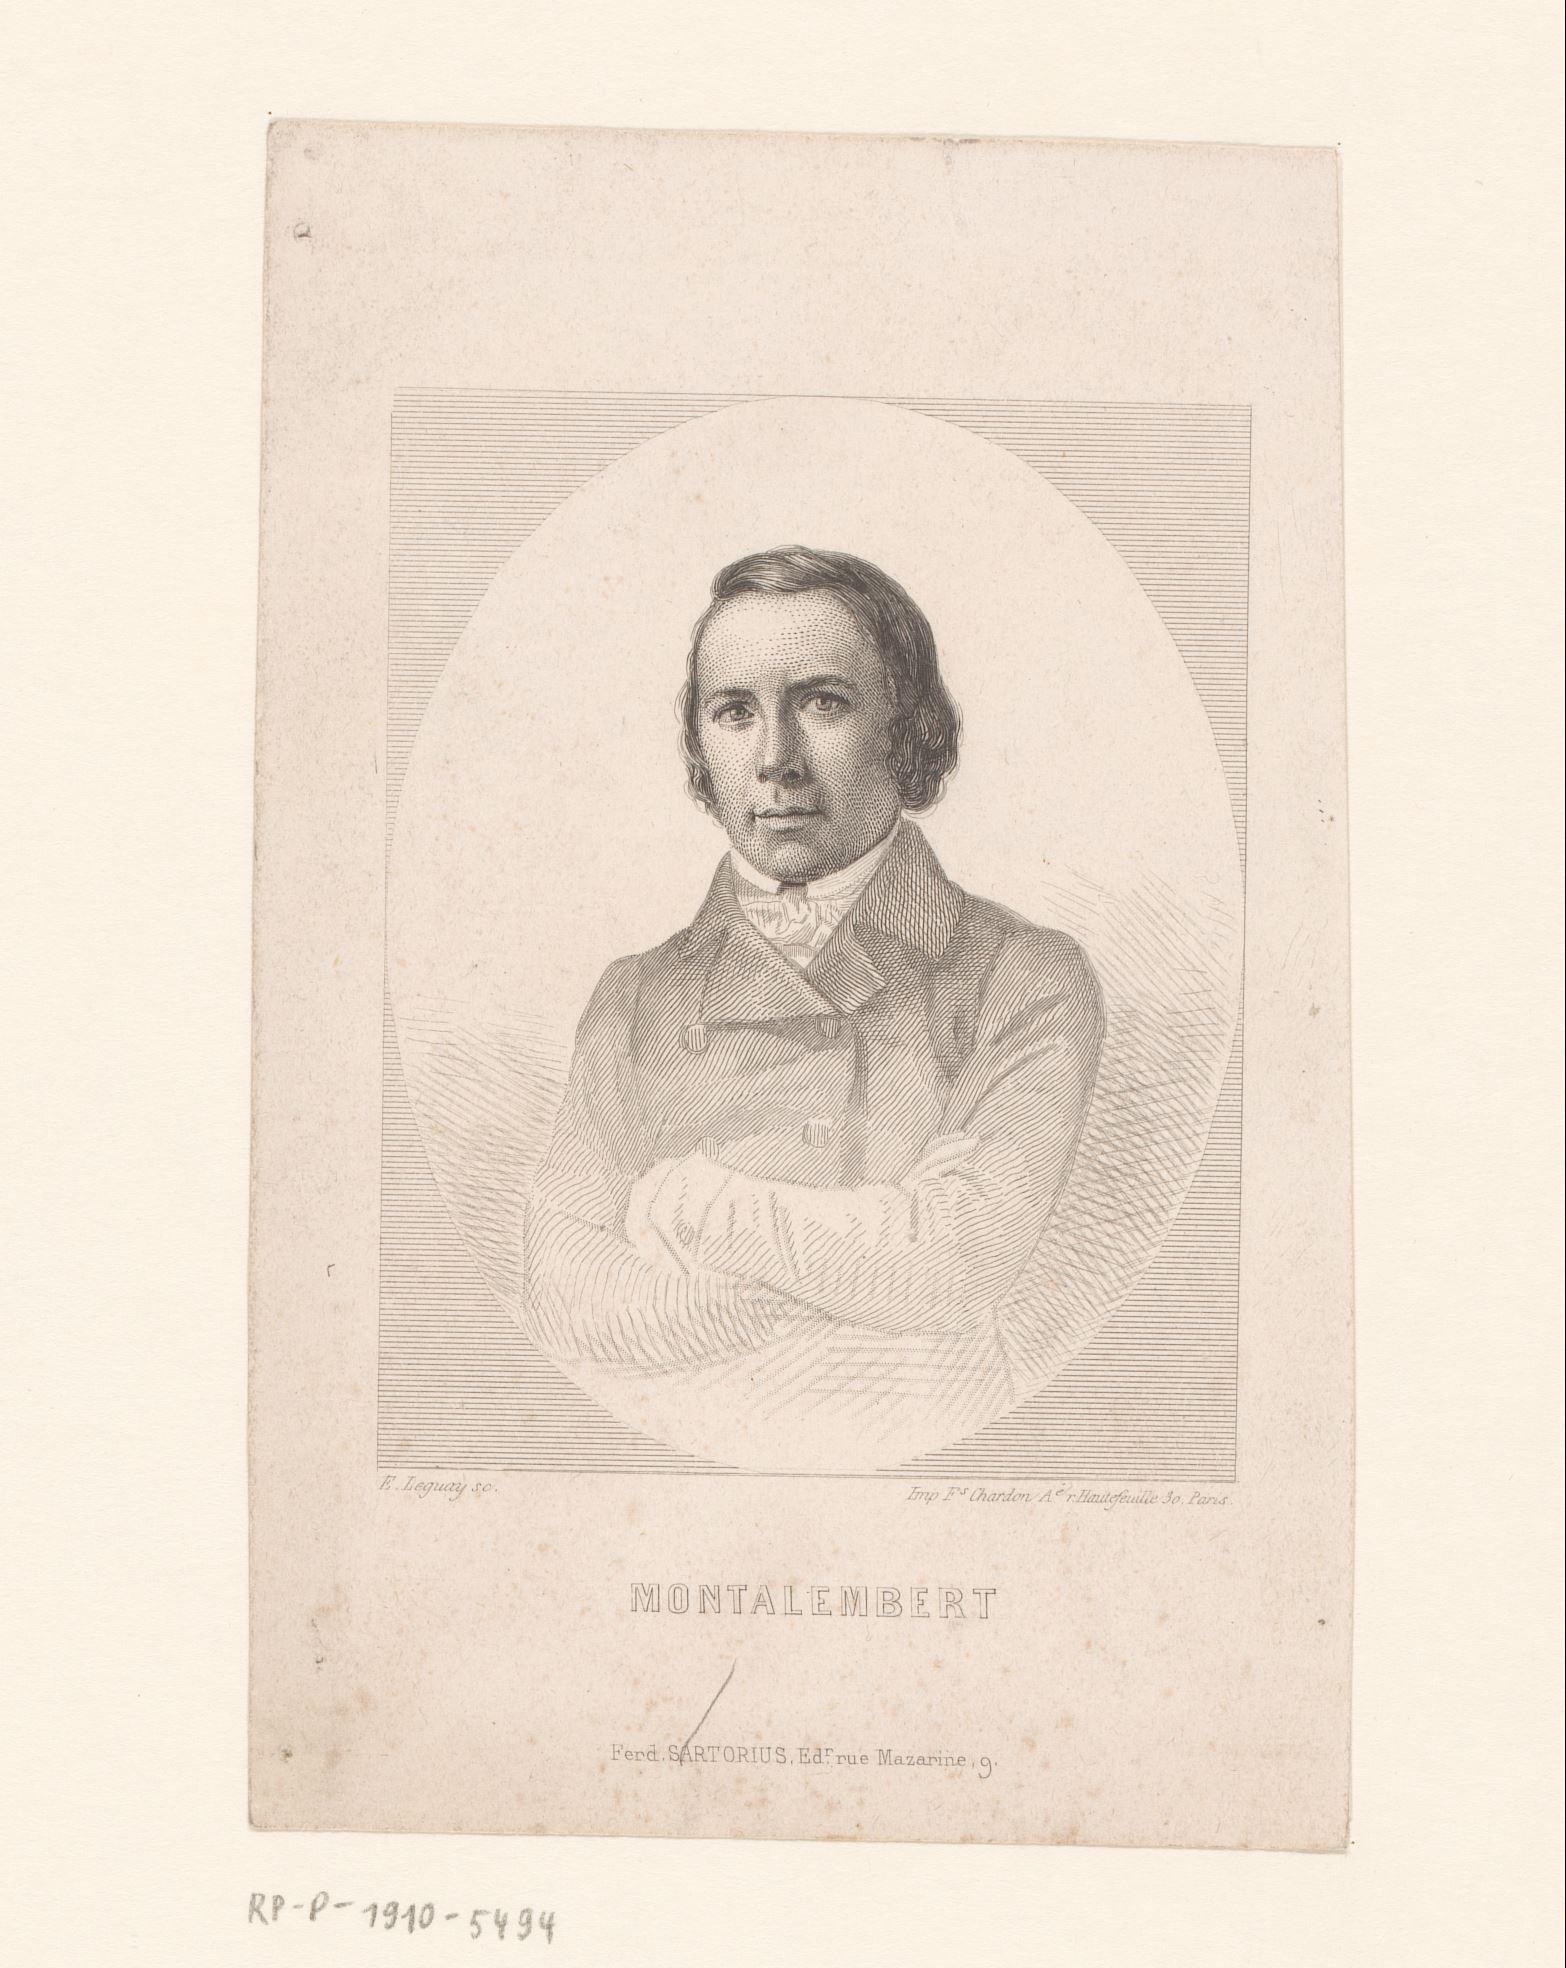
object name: print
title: Portret van Charles de Montalembert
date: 1832-1910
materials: paper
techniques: engraving, etching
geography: paris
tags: london, paris, earl, politician, historical persons, portrait of a writer, politician, e.g. party leader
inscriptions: collector's mark: Lugt 2228